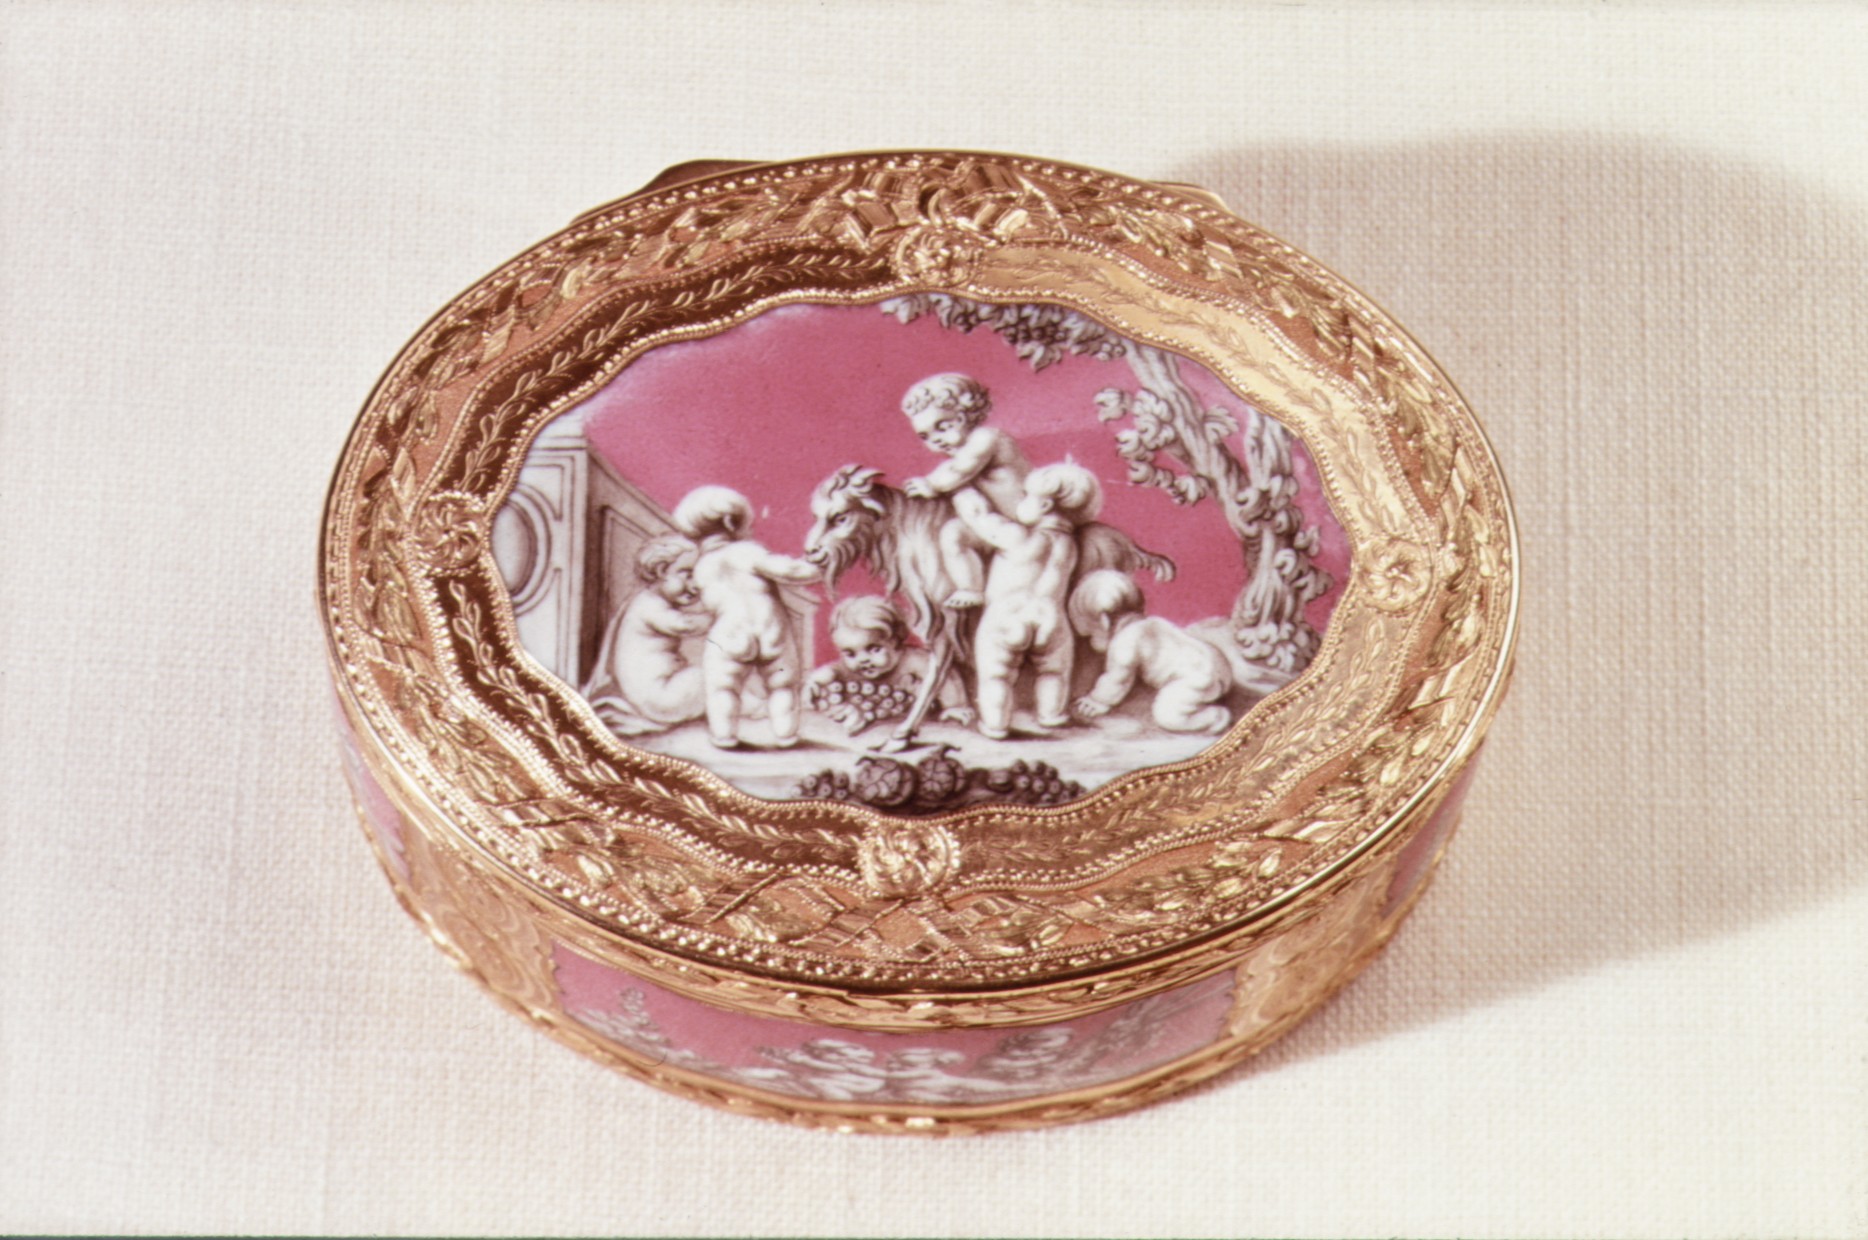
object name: snuffbox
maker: louis charonnat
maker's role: maker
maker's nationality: french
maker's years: 1748-1780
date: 1763-1764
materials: enamel, gold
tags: children,goats